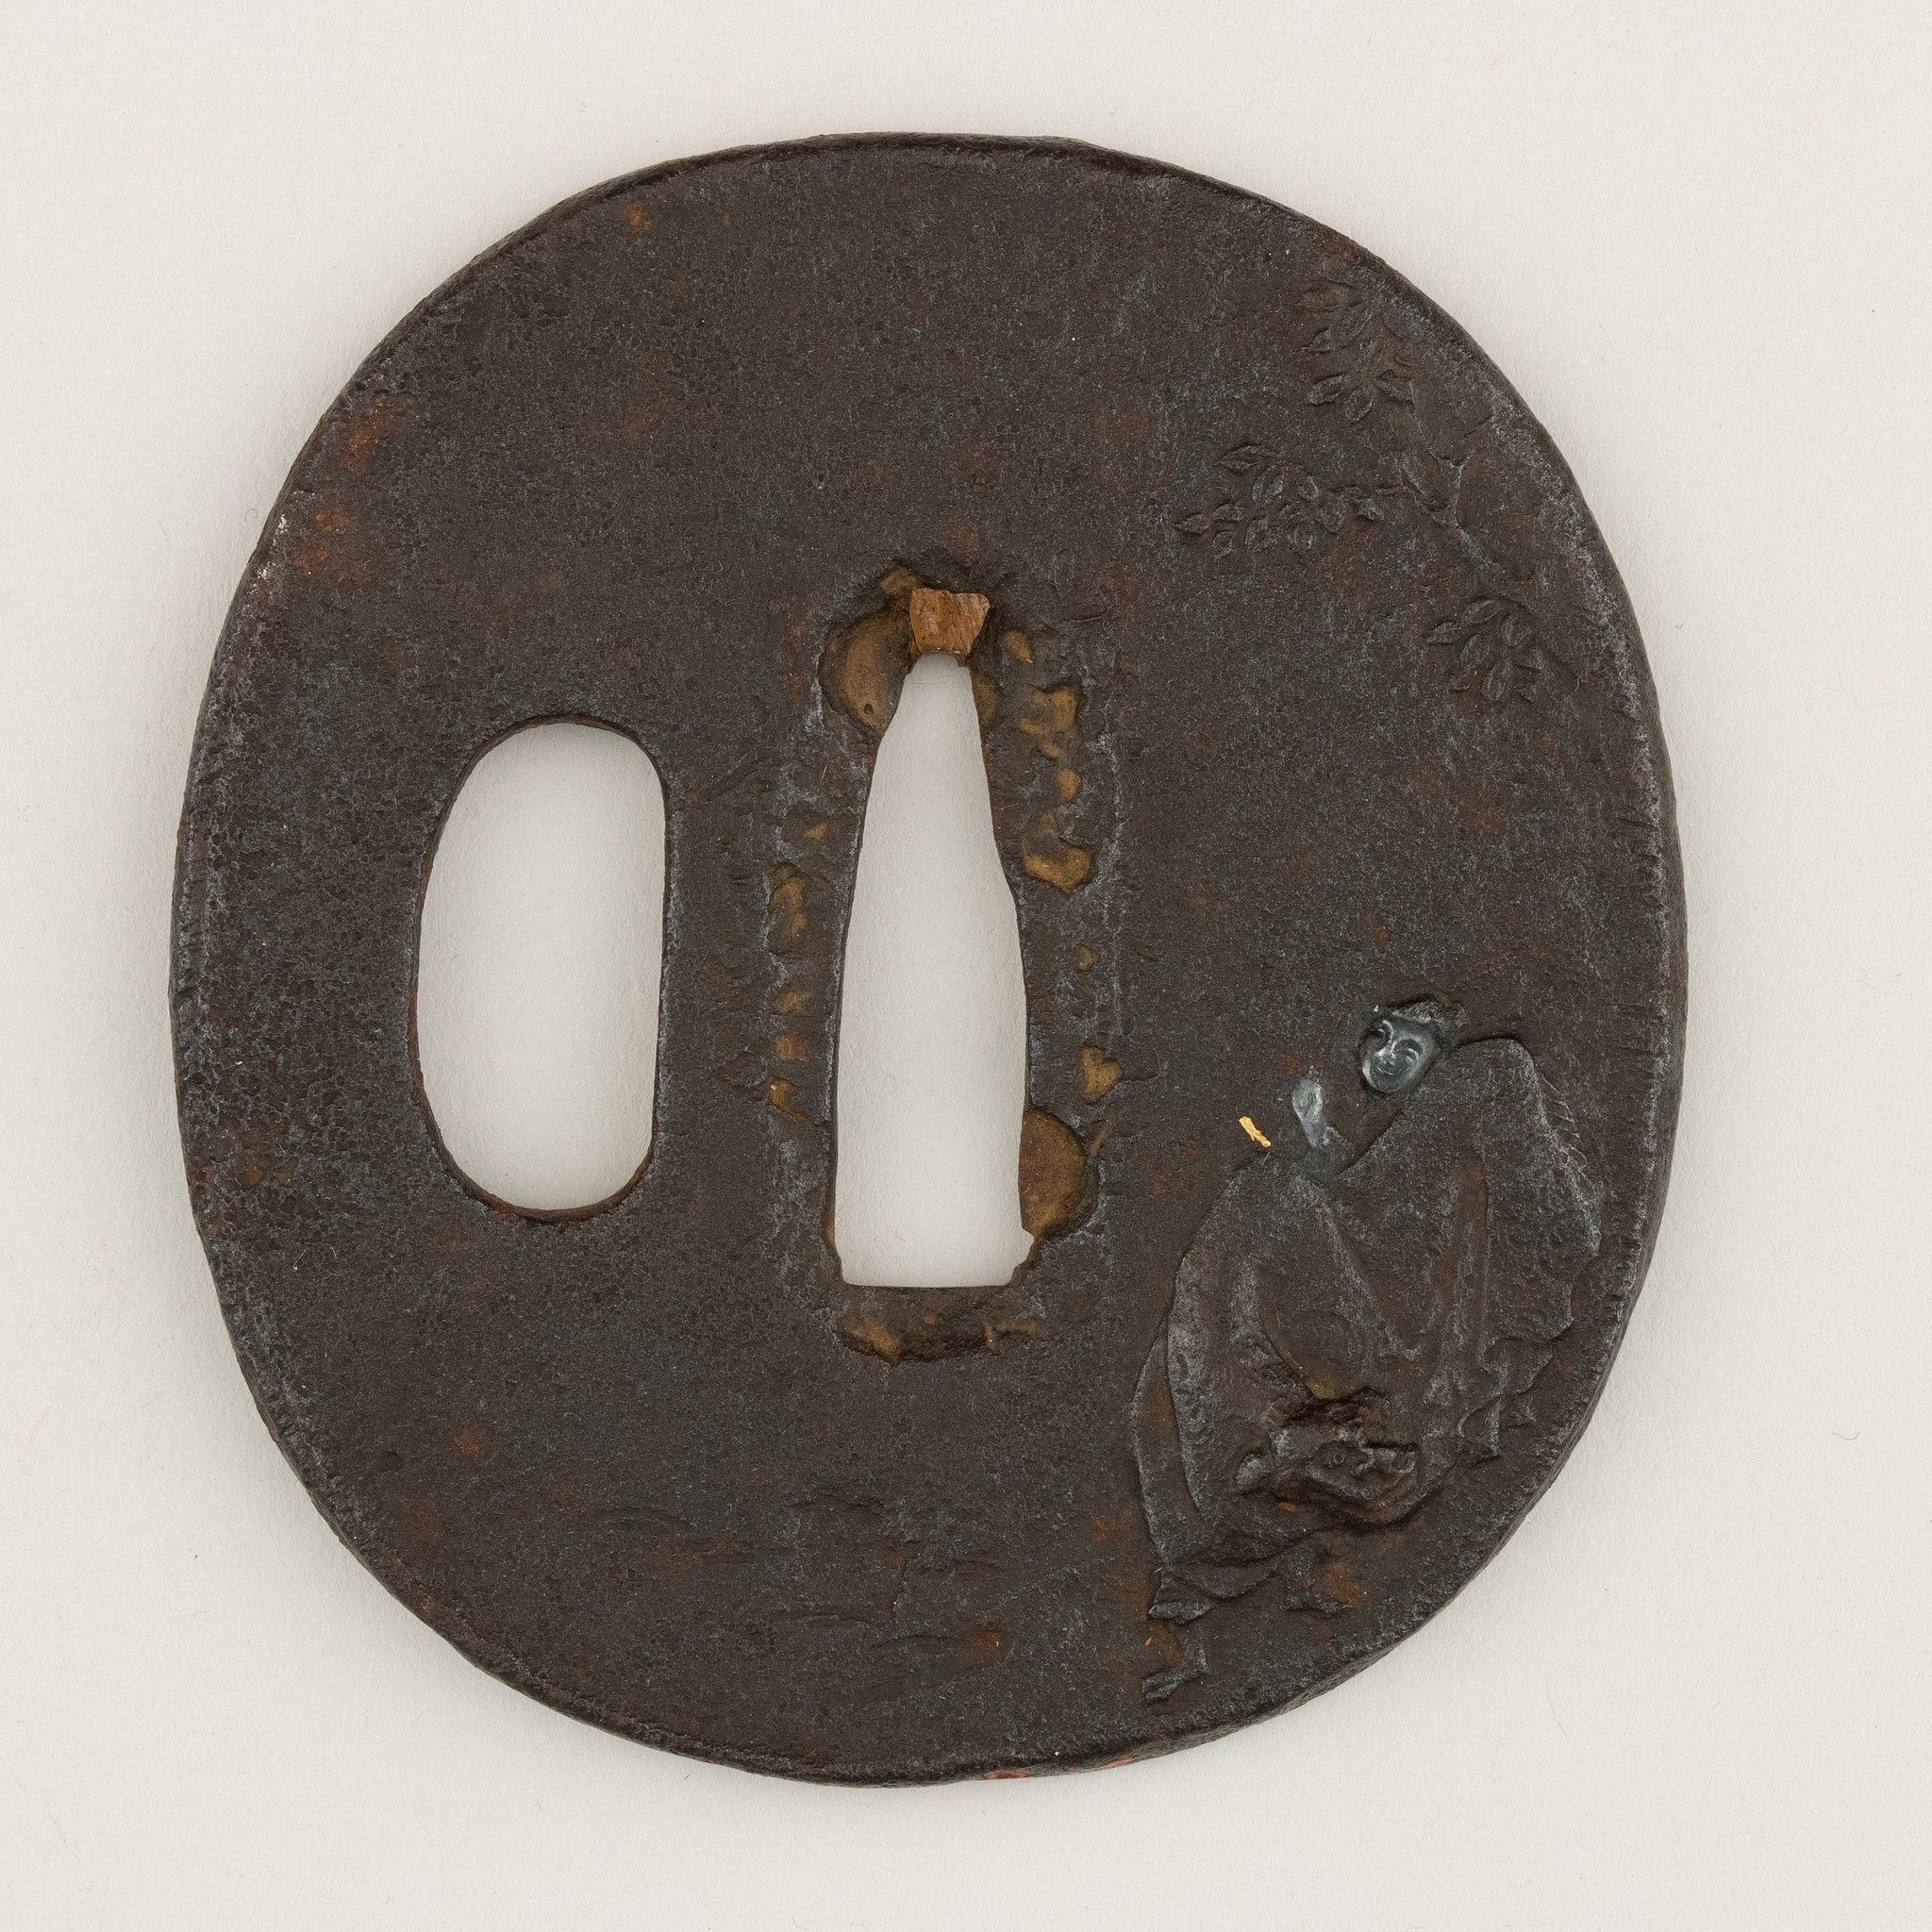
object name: sword guard tsuba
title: Sword Guard (Tsuba)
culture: japanese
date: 1501-1900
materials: gold, iron, silver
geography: japan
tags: human figures